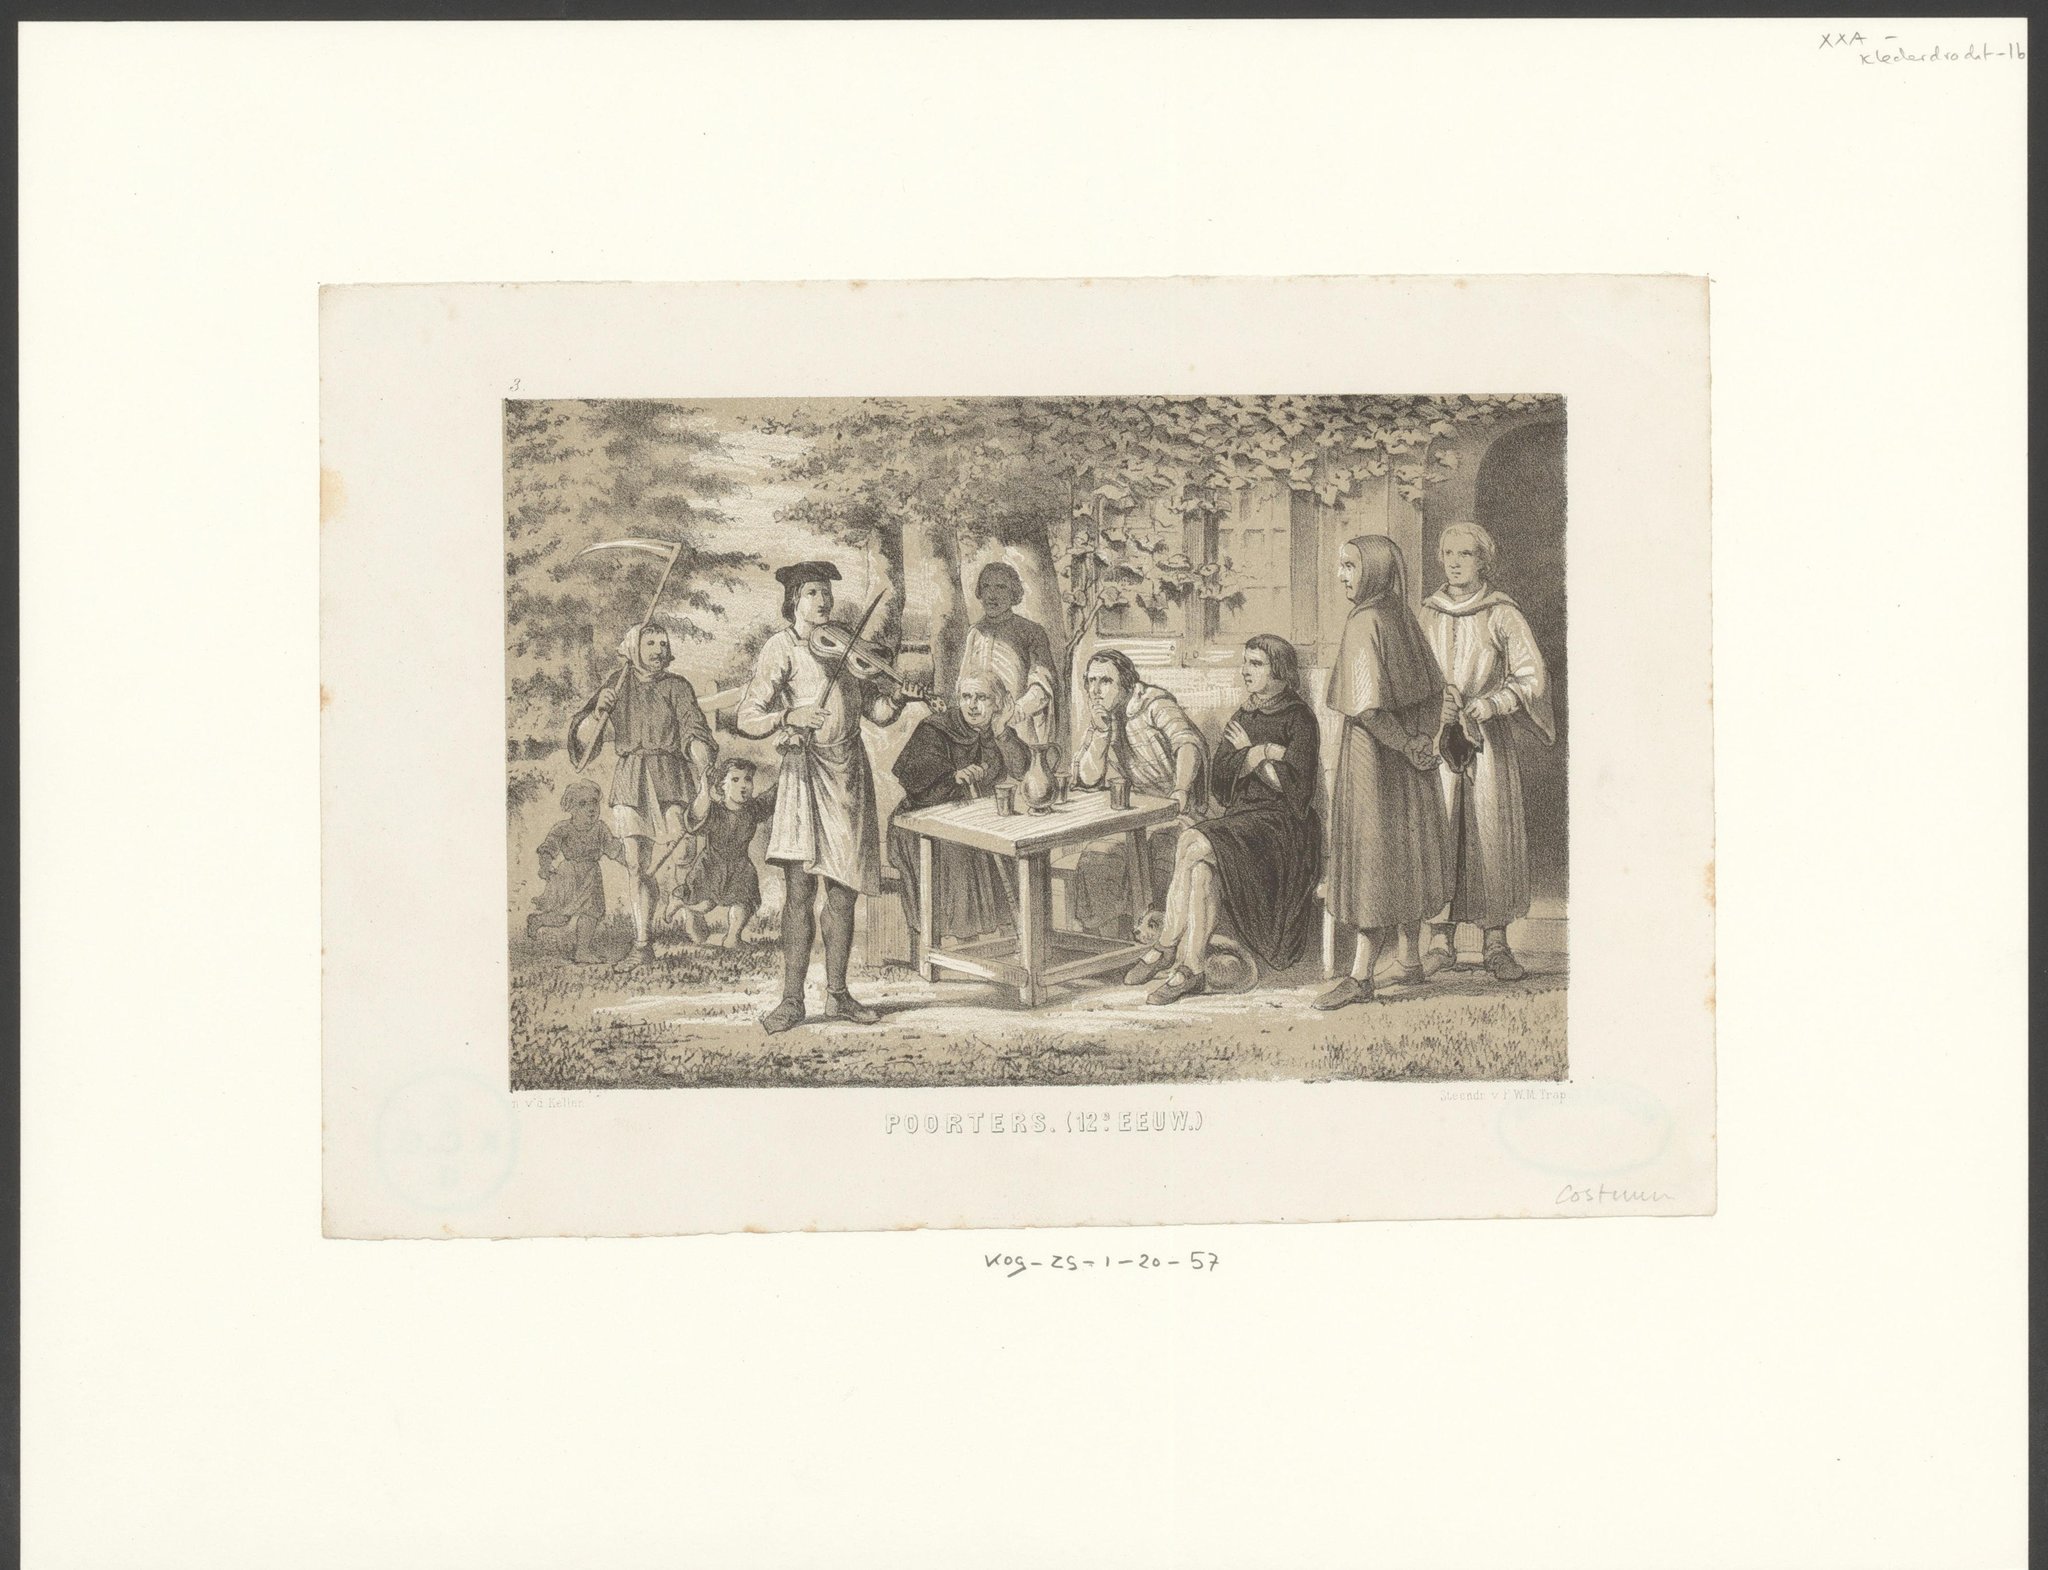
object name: print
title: Poorters. (12e eeuw)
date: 1875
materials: paper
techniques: tone lithography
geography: leiden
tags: violin, fiddle, hotel, hostelry, inn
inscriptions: stamp, collector's mark: Lugt 1641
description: Muzikant speelt voor de gasten buiten bij een herberg, 12e eeuw. Onderwerpsrubrieken binnen de Atlas Zeden en Gewoonten: Zeden en Gewoonten in Engeren Zin, De Kleeding, Kleederdrachten (tijdvakken), De 15e eeuw.